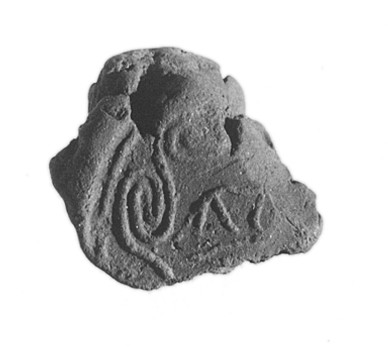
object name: sealing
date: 2030-1640 BCE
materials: clay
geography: egypt